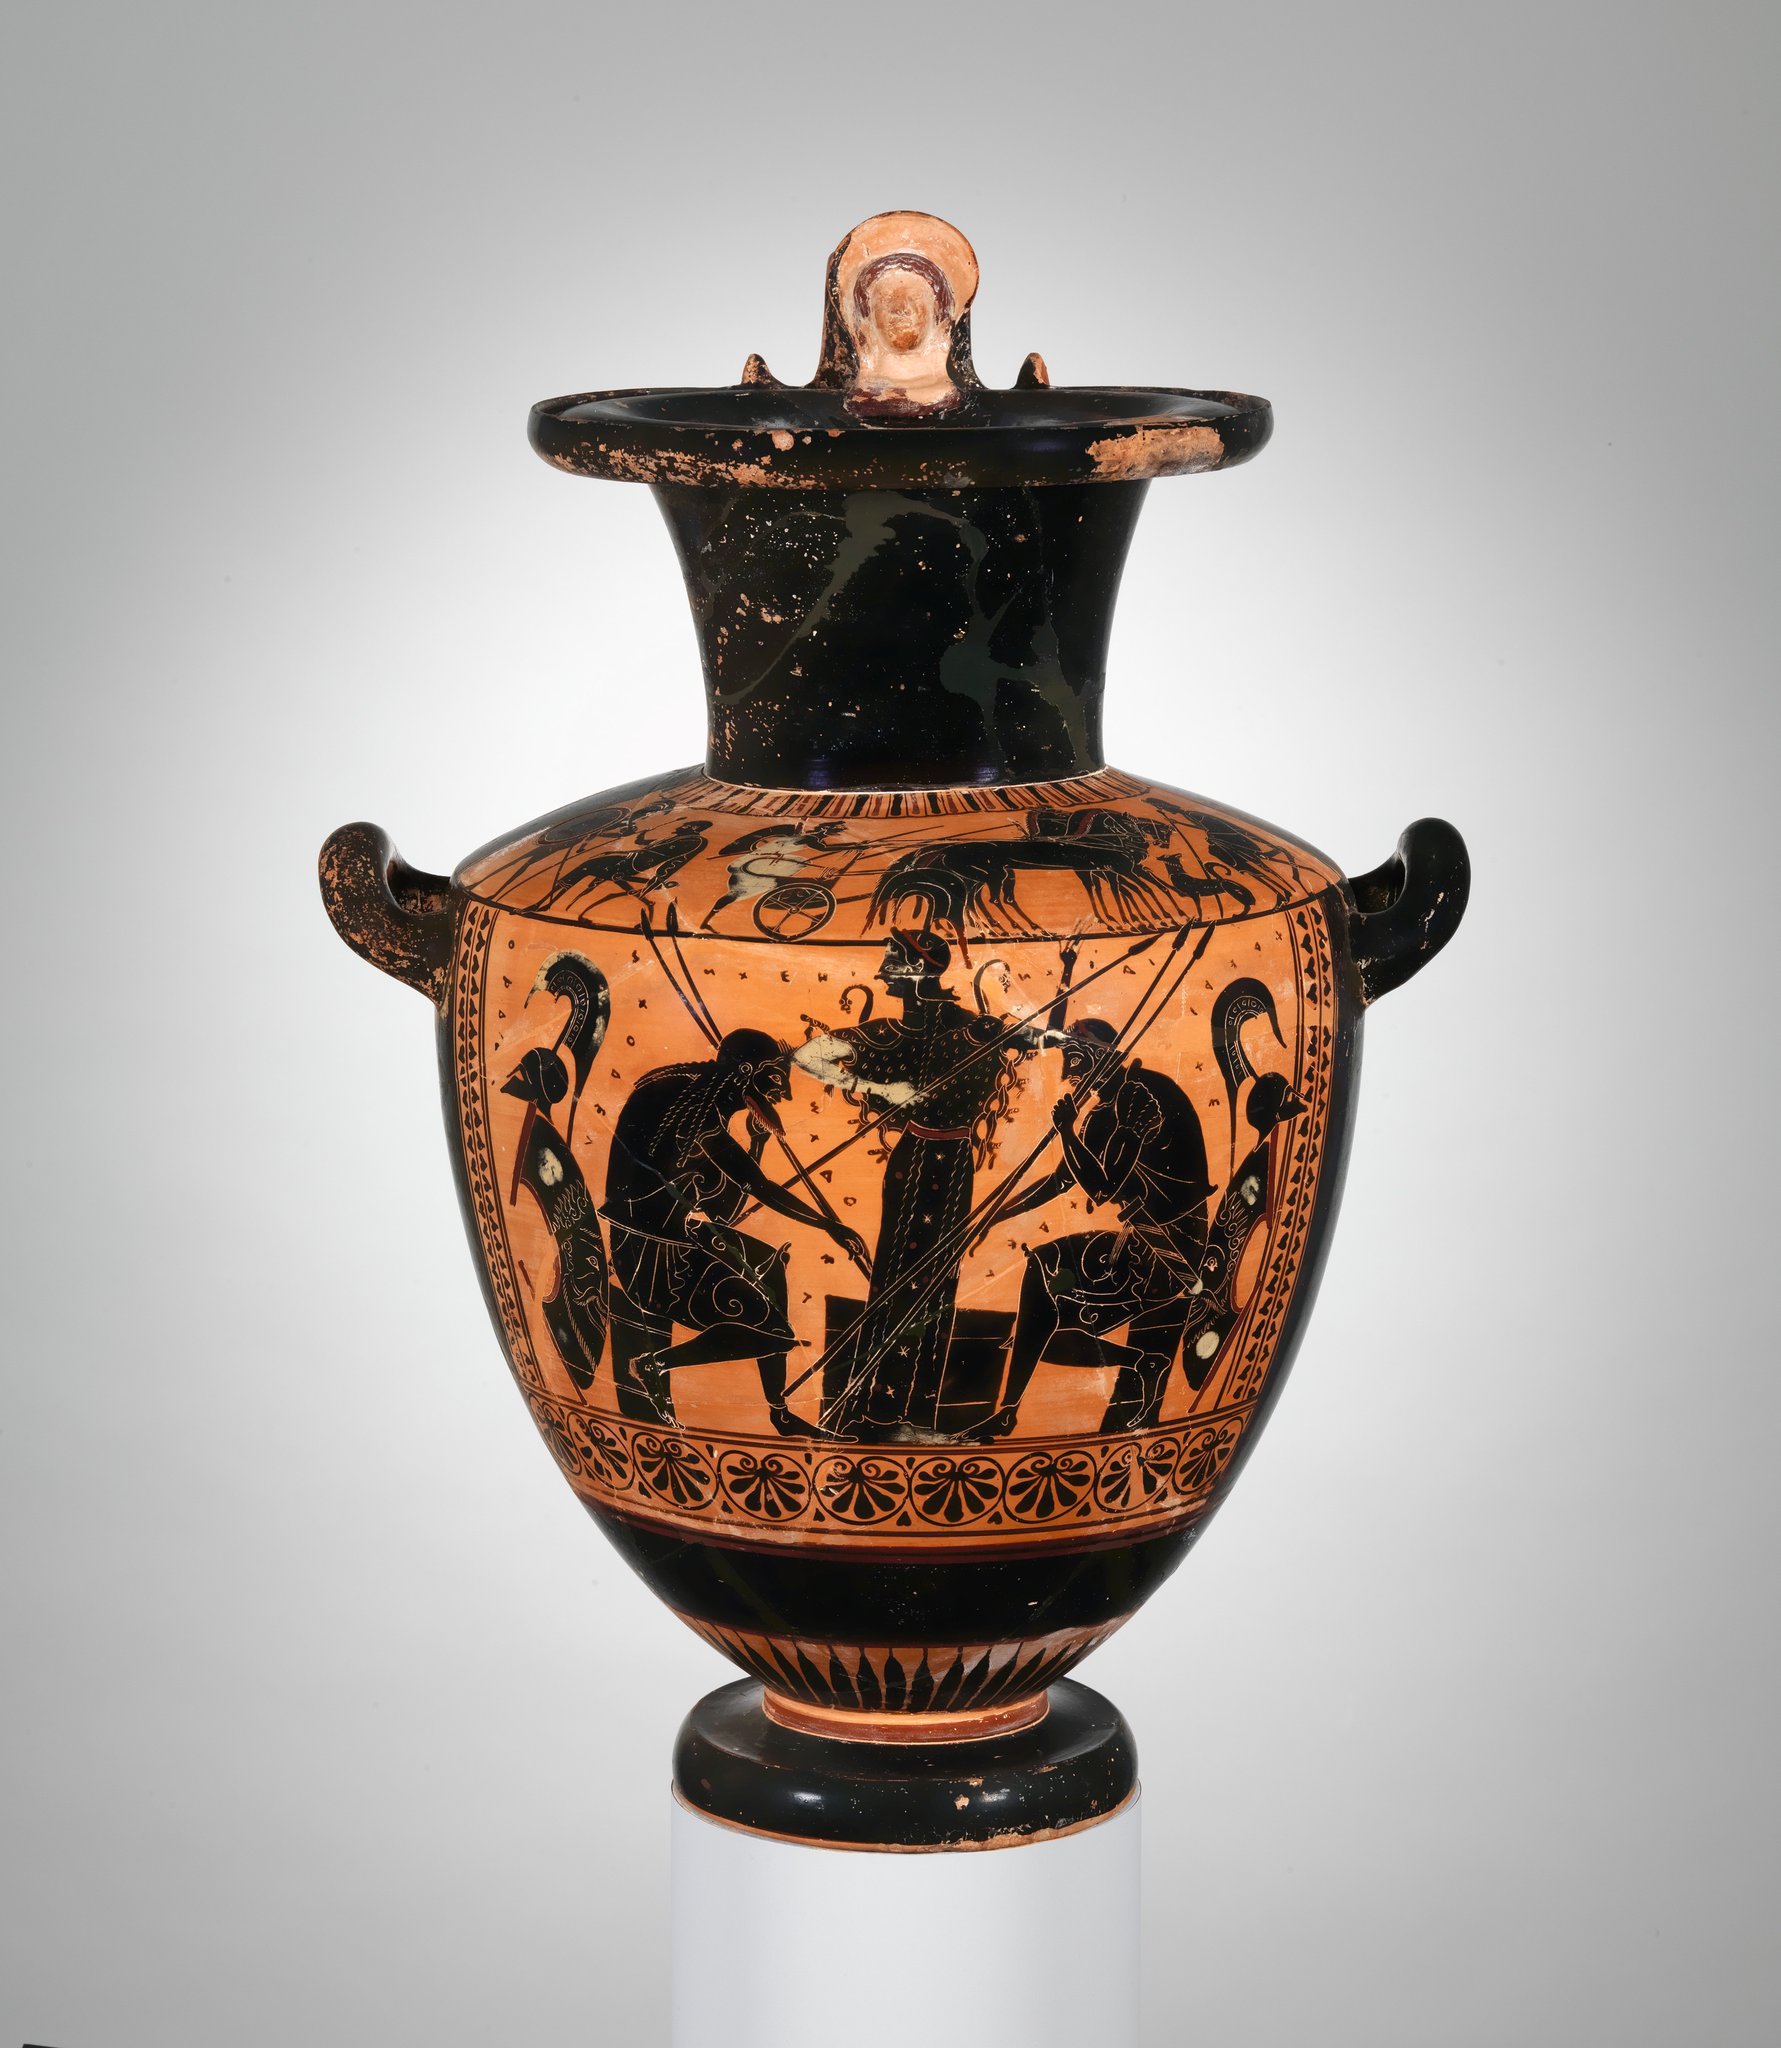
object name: hydria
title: Terracotta hydria (water jar)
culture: greek, attic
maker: leagros group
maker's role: artist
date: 510 BCE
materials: terracotta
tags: trojan war,athena,achilles,horses,chariots,games,ajax